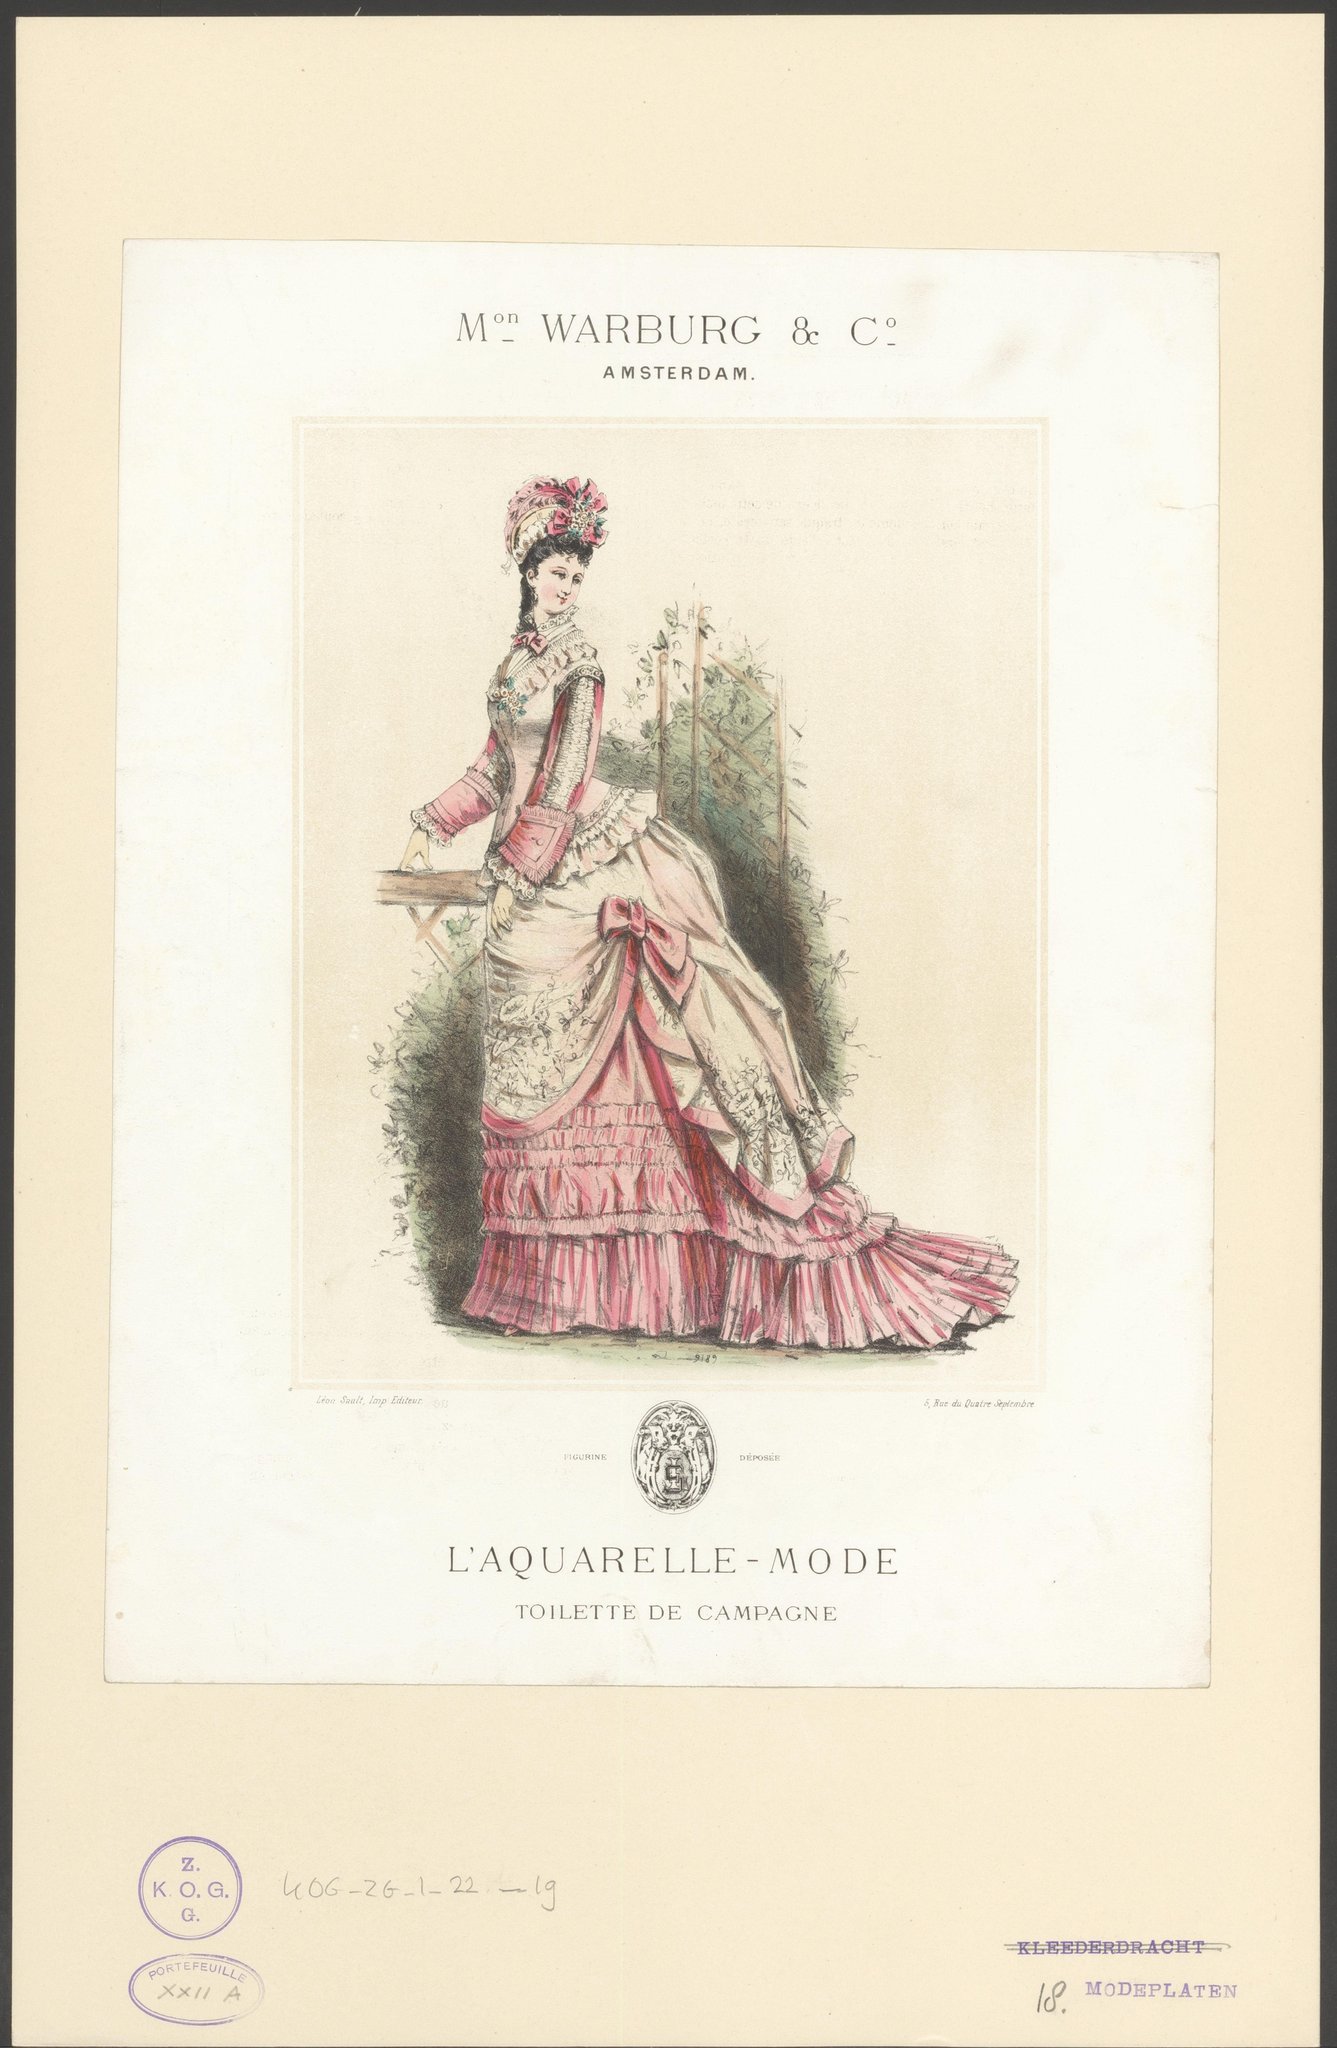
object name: fashion print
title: Toilette de Campagne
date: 1875-1886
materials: paper, watercolor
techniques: hand coloring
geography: paris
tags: fashion plates, clothes, costume (+ women's clothes), dress, gown (+ women's clothes)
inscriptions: collector's mark: Lugt 1641, collector's mark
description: Vrouw in roze en witte japon, staande naar links, de hand op een trellis. Met vermelding van 'Mon. Warburg & Co. Amsterdam'. Prent uit het modetijdschrift L'Aquarelle-Mode (1866-1892). nr. 9189. Onderwerpsrubrieken binnen de Atlas Zeden en Gewoonten: De Kleeding, Modeplaten.